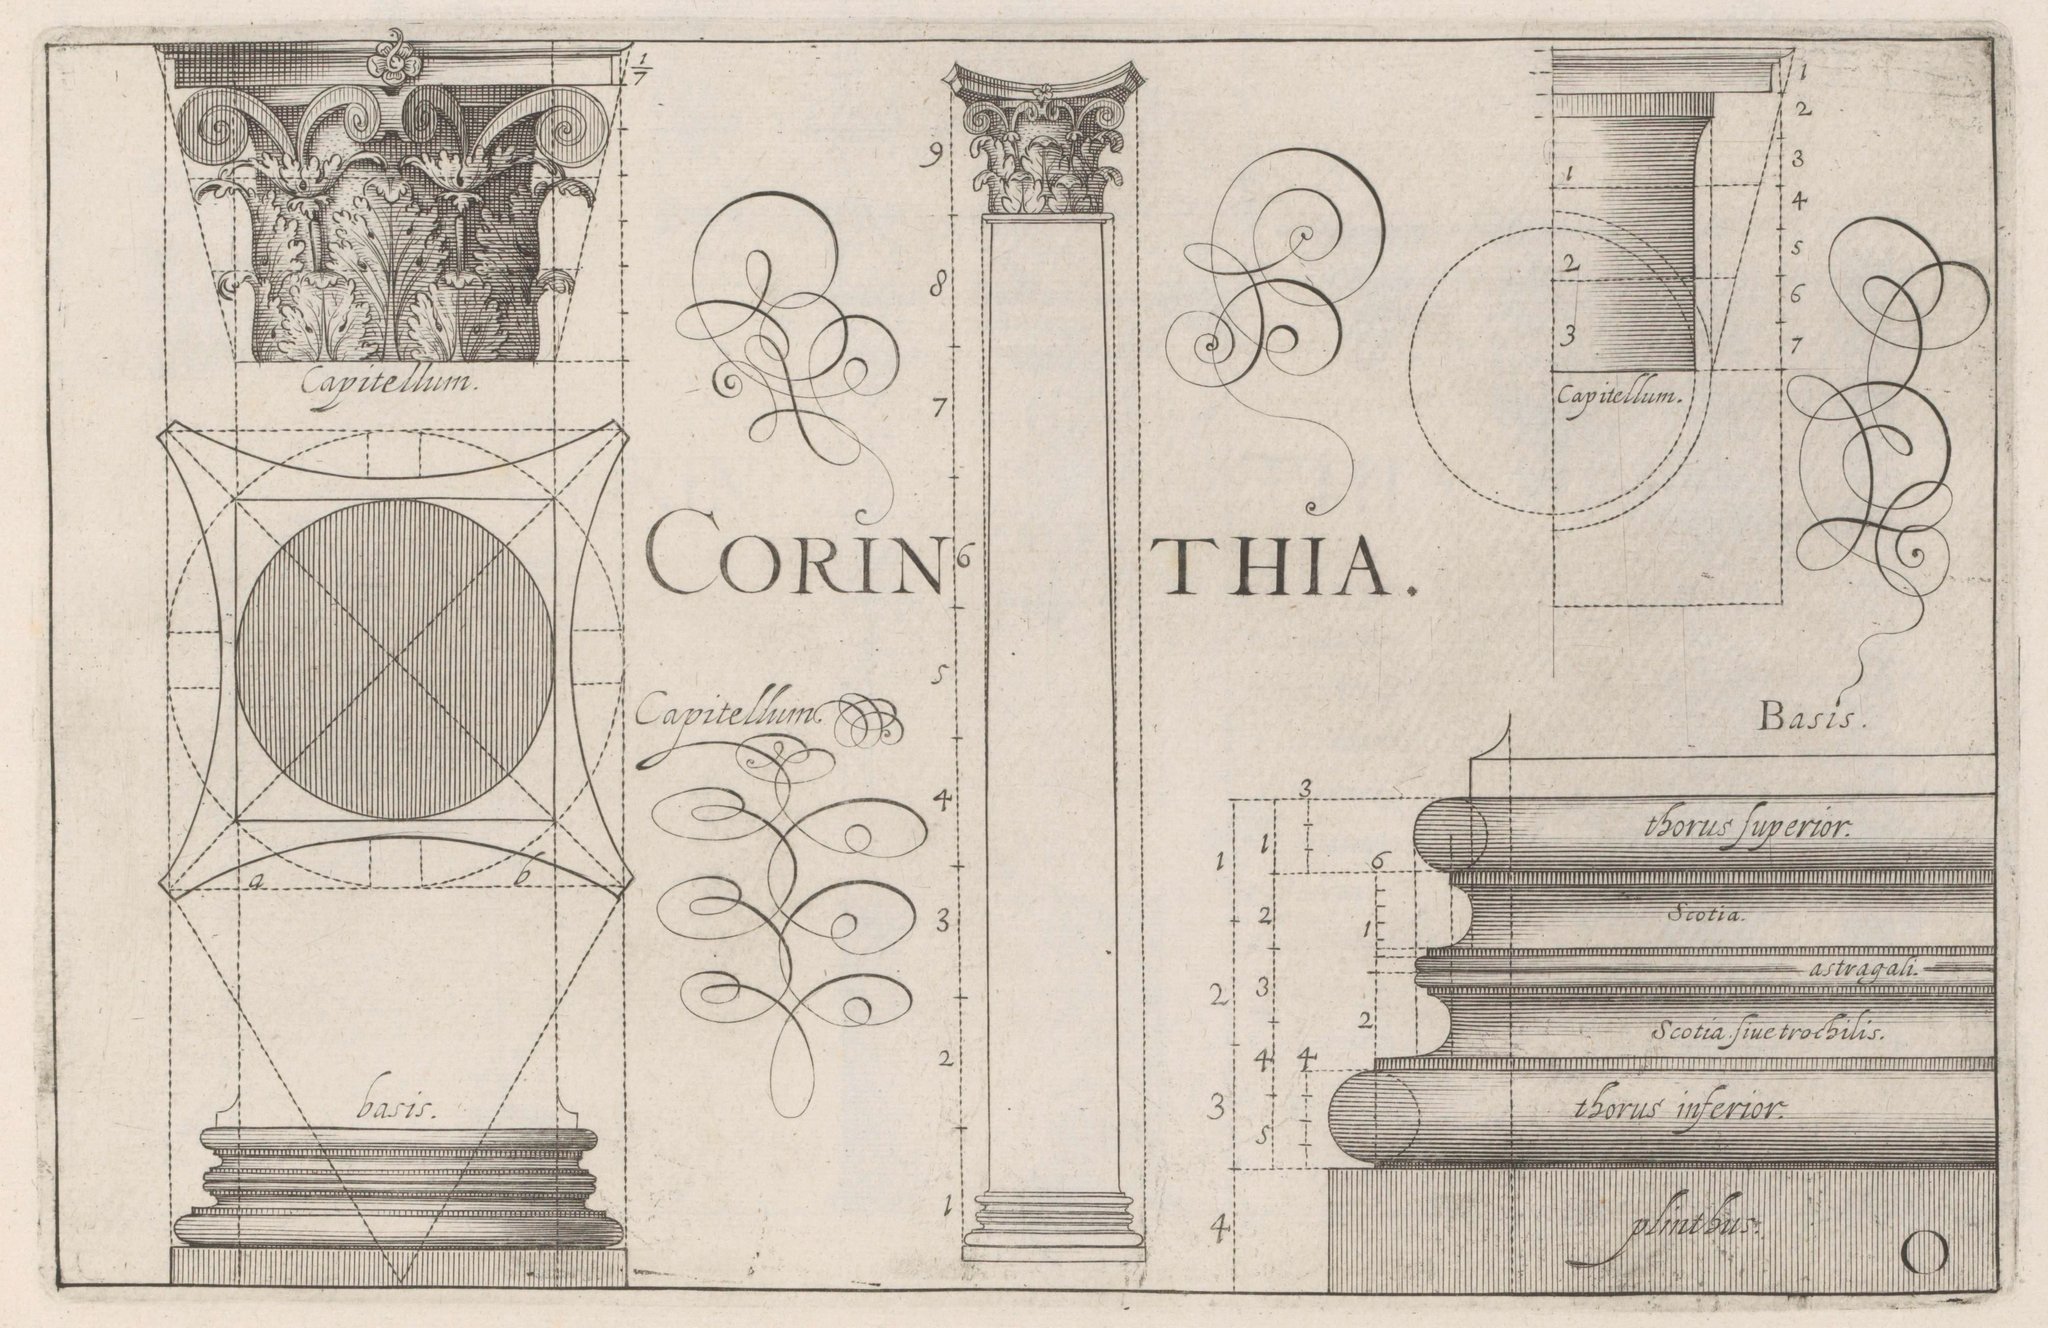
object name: album leaf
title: Corinthia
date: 1606-1607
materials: paper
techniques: engraving, etching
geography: the hague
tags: corinthian order ~ architecture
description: Constructie en details van de Korinthische bouworde, waaronder basementen en kapitelen. Rechtsonder: O. Prent maakt deel uit van een album.